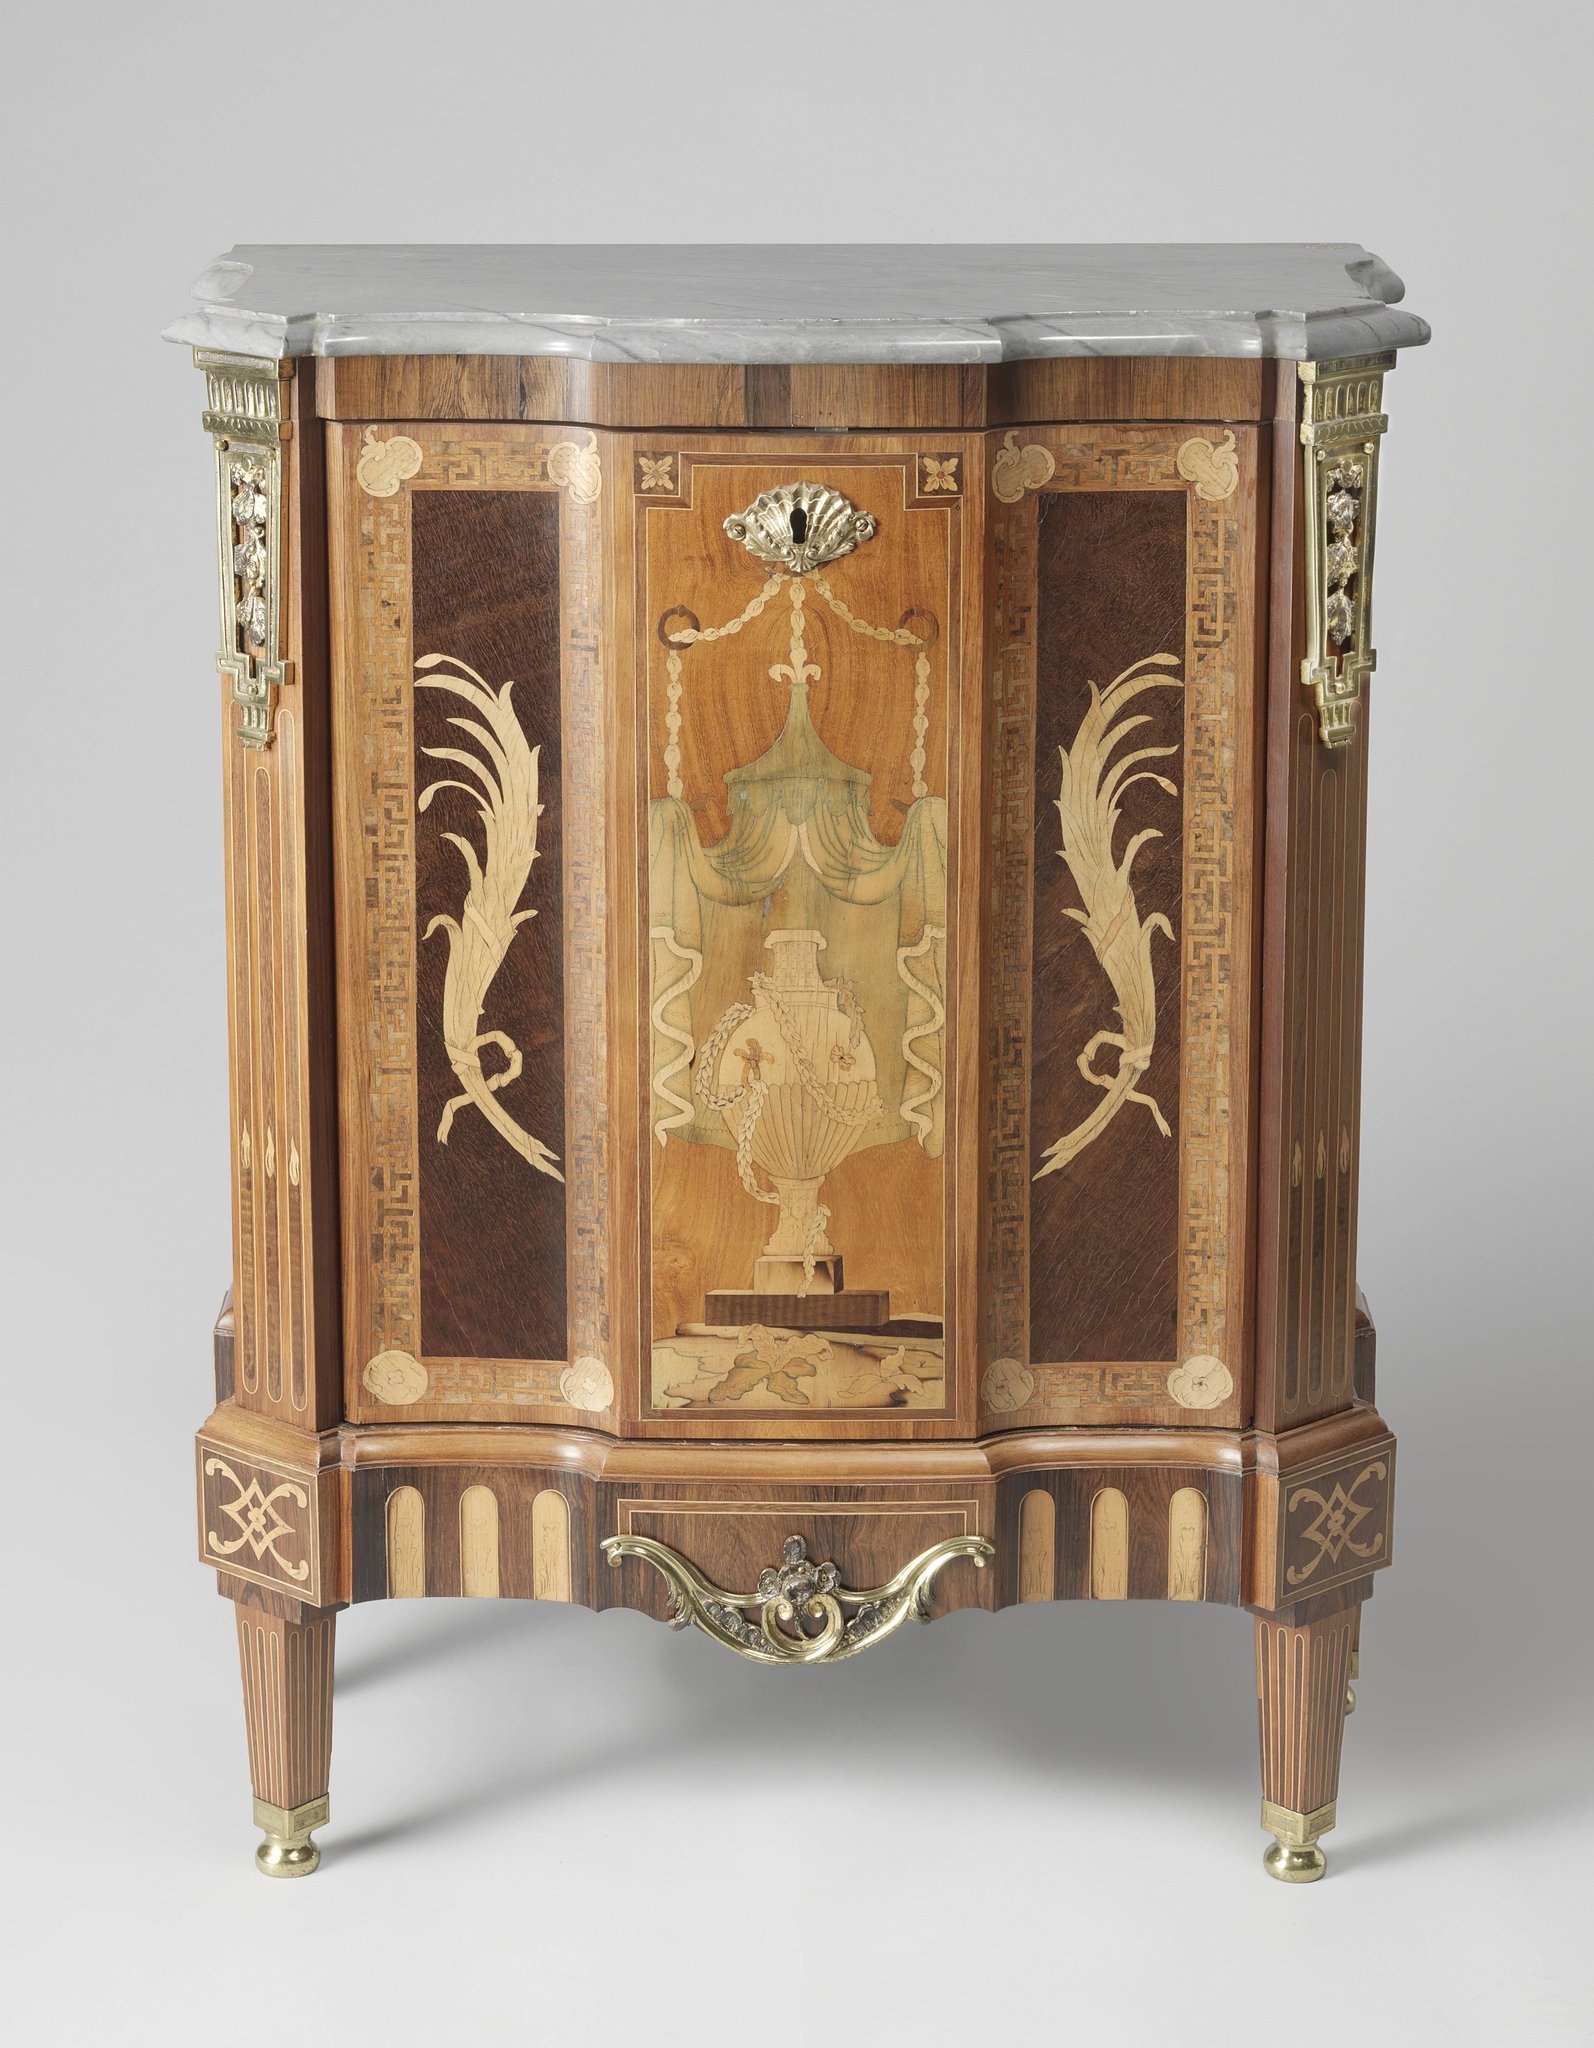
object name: case furniture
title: Commode and two cupboards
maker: Anonymous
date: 1770-1790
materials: copper, wood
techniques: gilding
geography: netherlands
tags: ornaments ~ art, garden vase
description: These three pieces of furniture were made in the French style, which was emulated in all large Dutch cities in the third quarter of the 17th century. This is evident from their form, the marquetry ornamentation, the gilded mounts and the marble tops. The m rquetry vases are taken from French prints and the mounts were probably cast from French examples. This ensemble is exceptionally elaborate by Dutch standards.